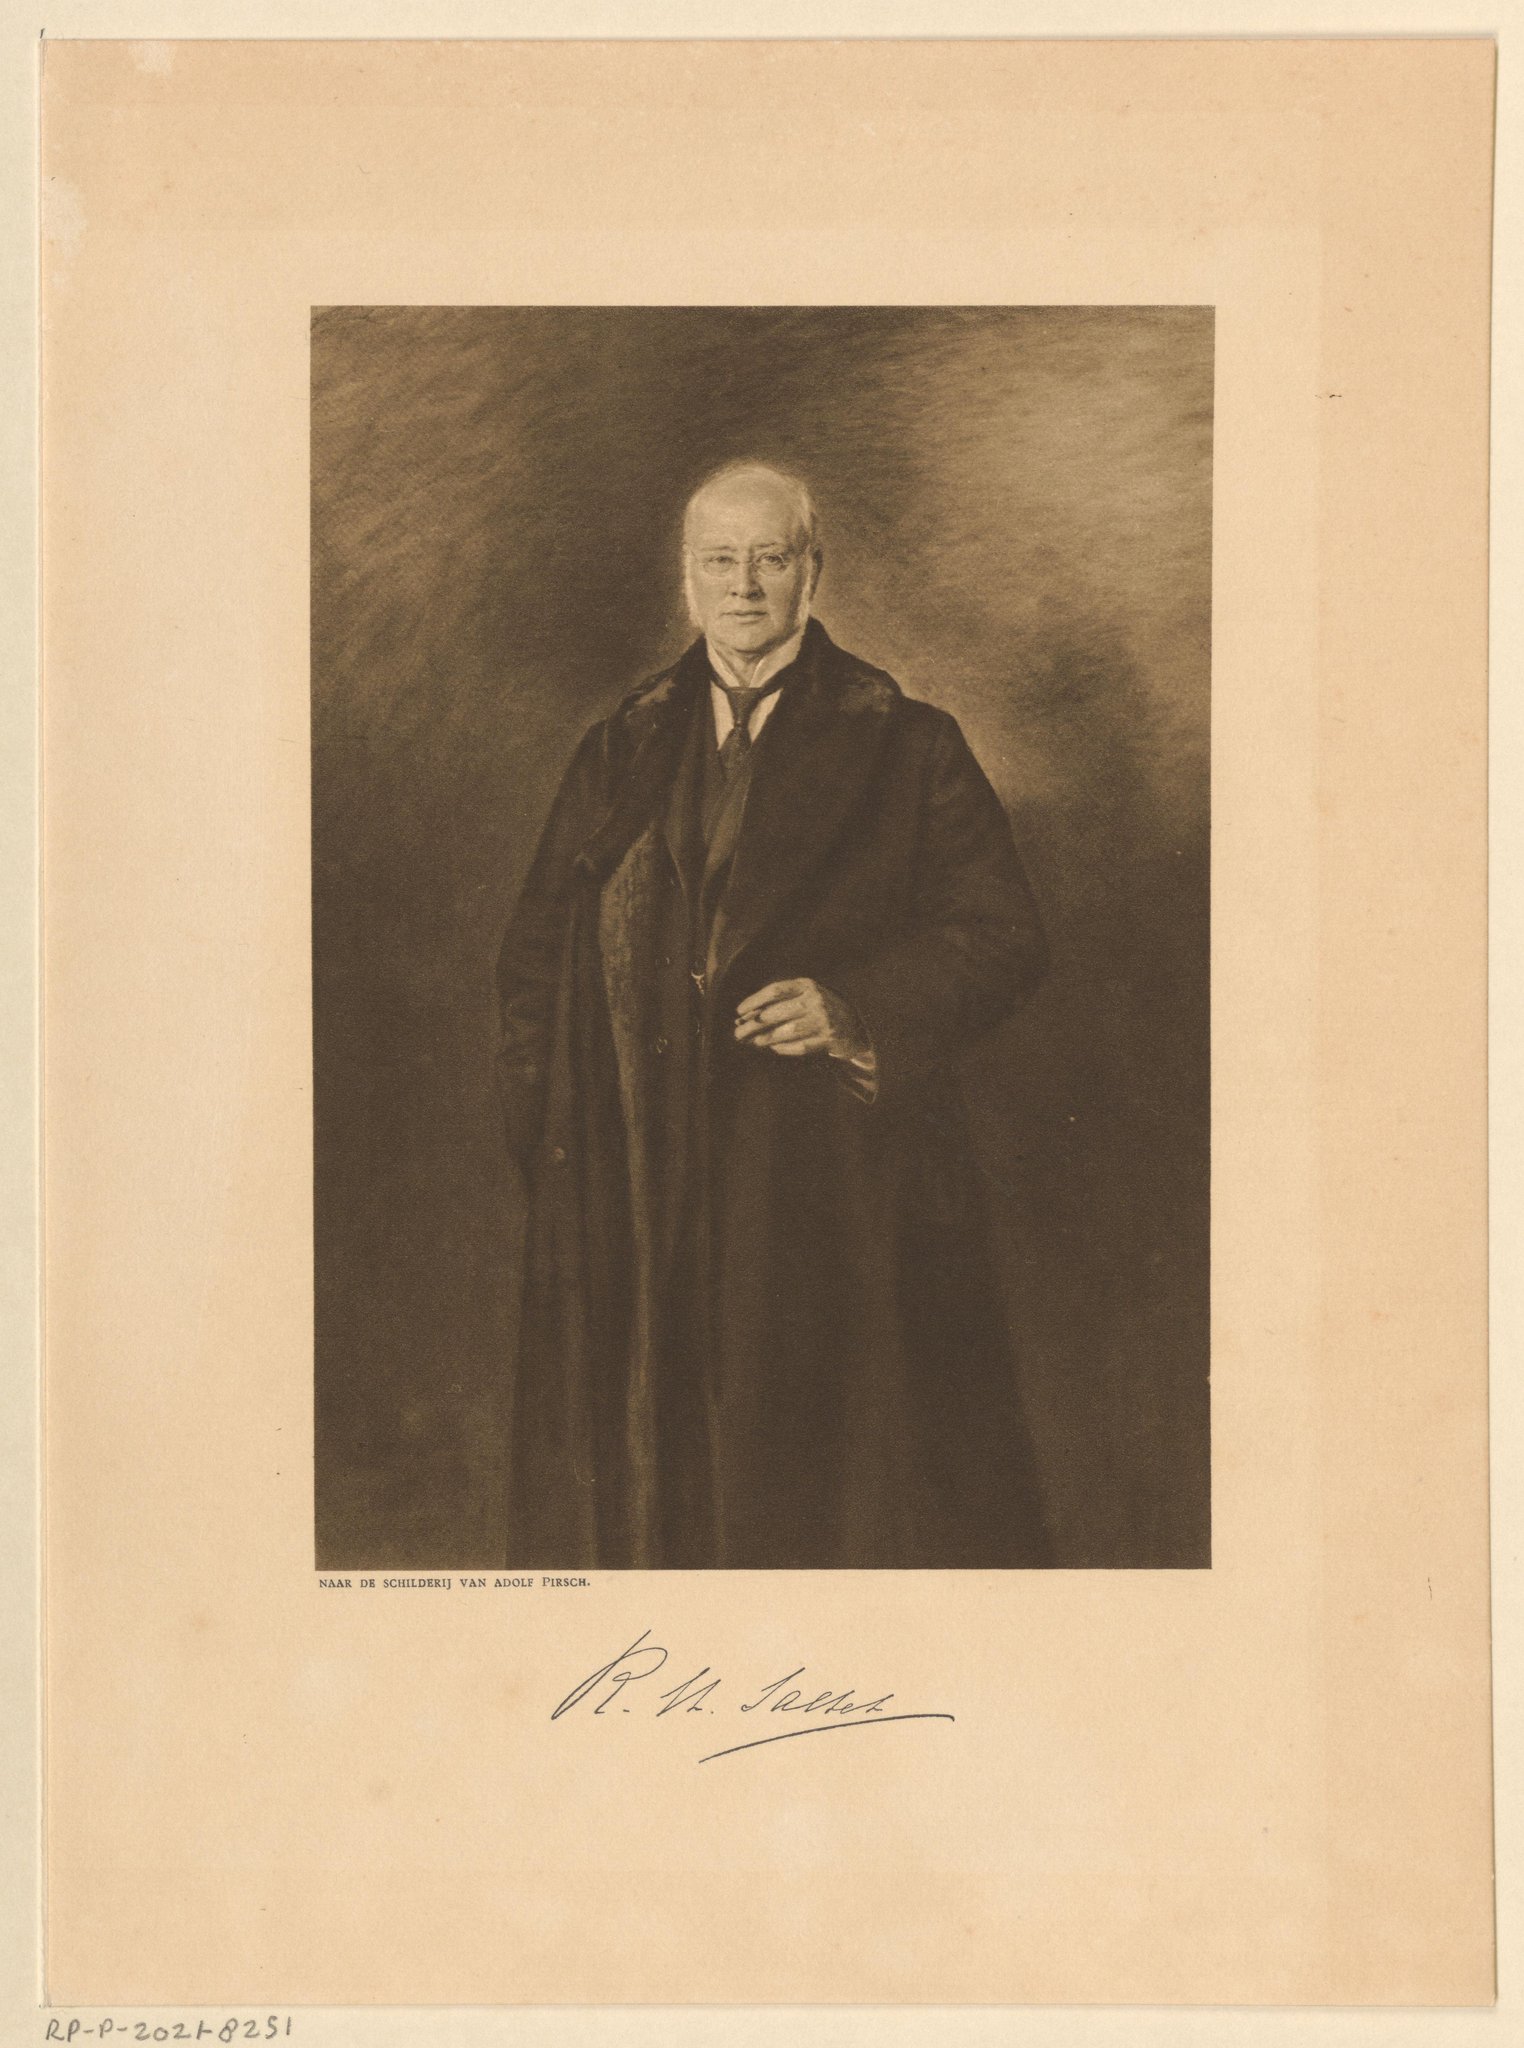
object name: photomechanical print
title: Portret van Rudolf Hendrik Saltet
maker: Anonymous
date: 1919-1950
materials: paper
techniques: rotogravure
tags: amsterdam, historical persons, professor